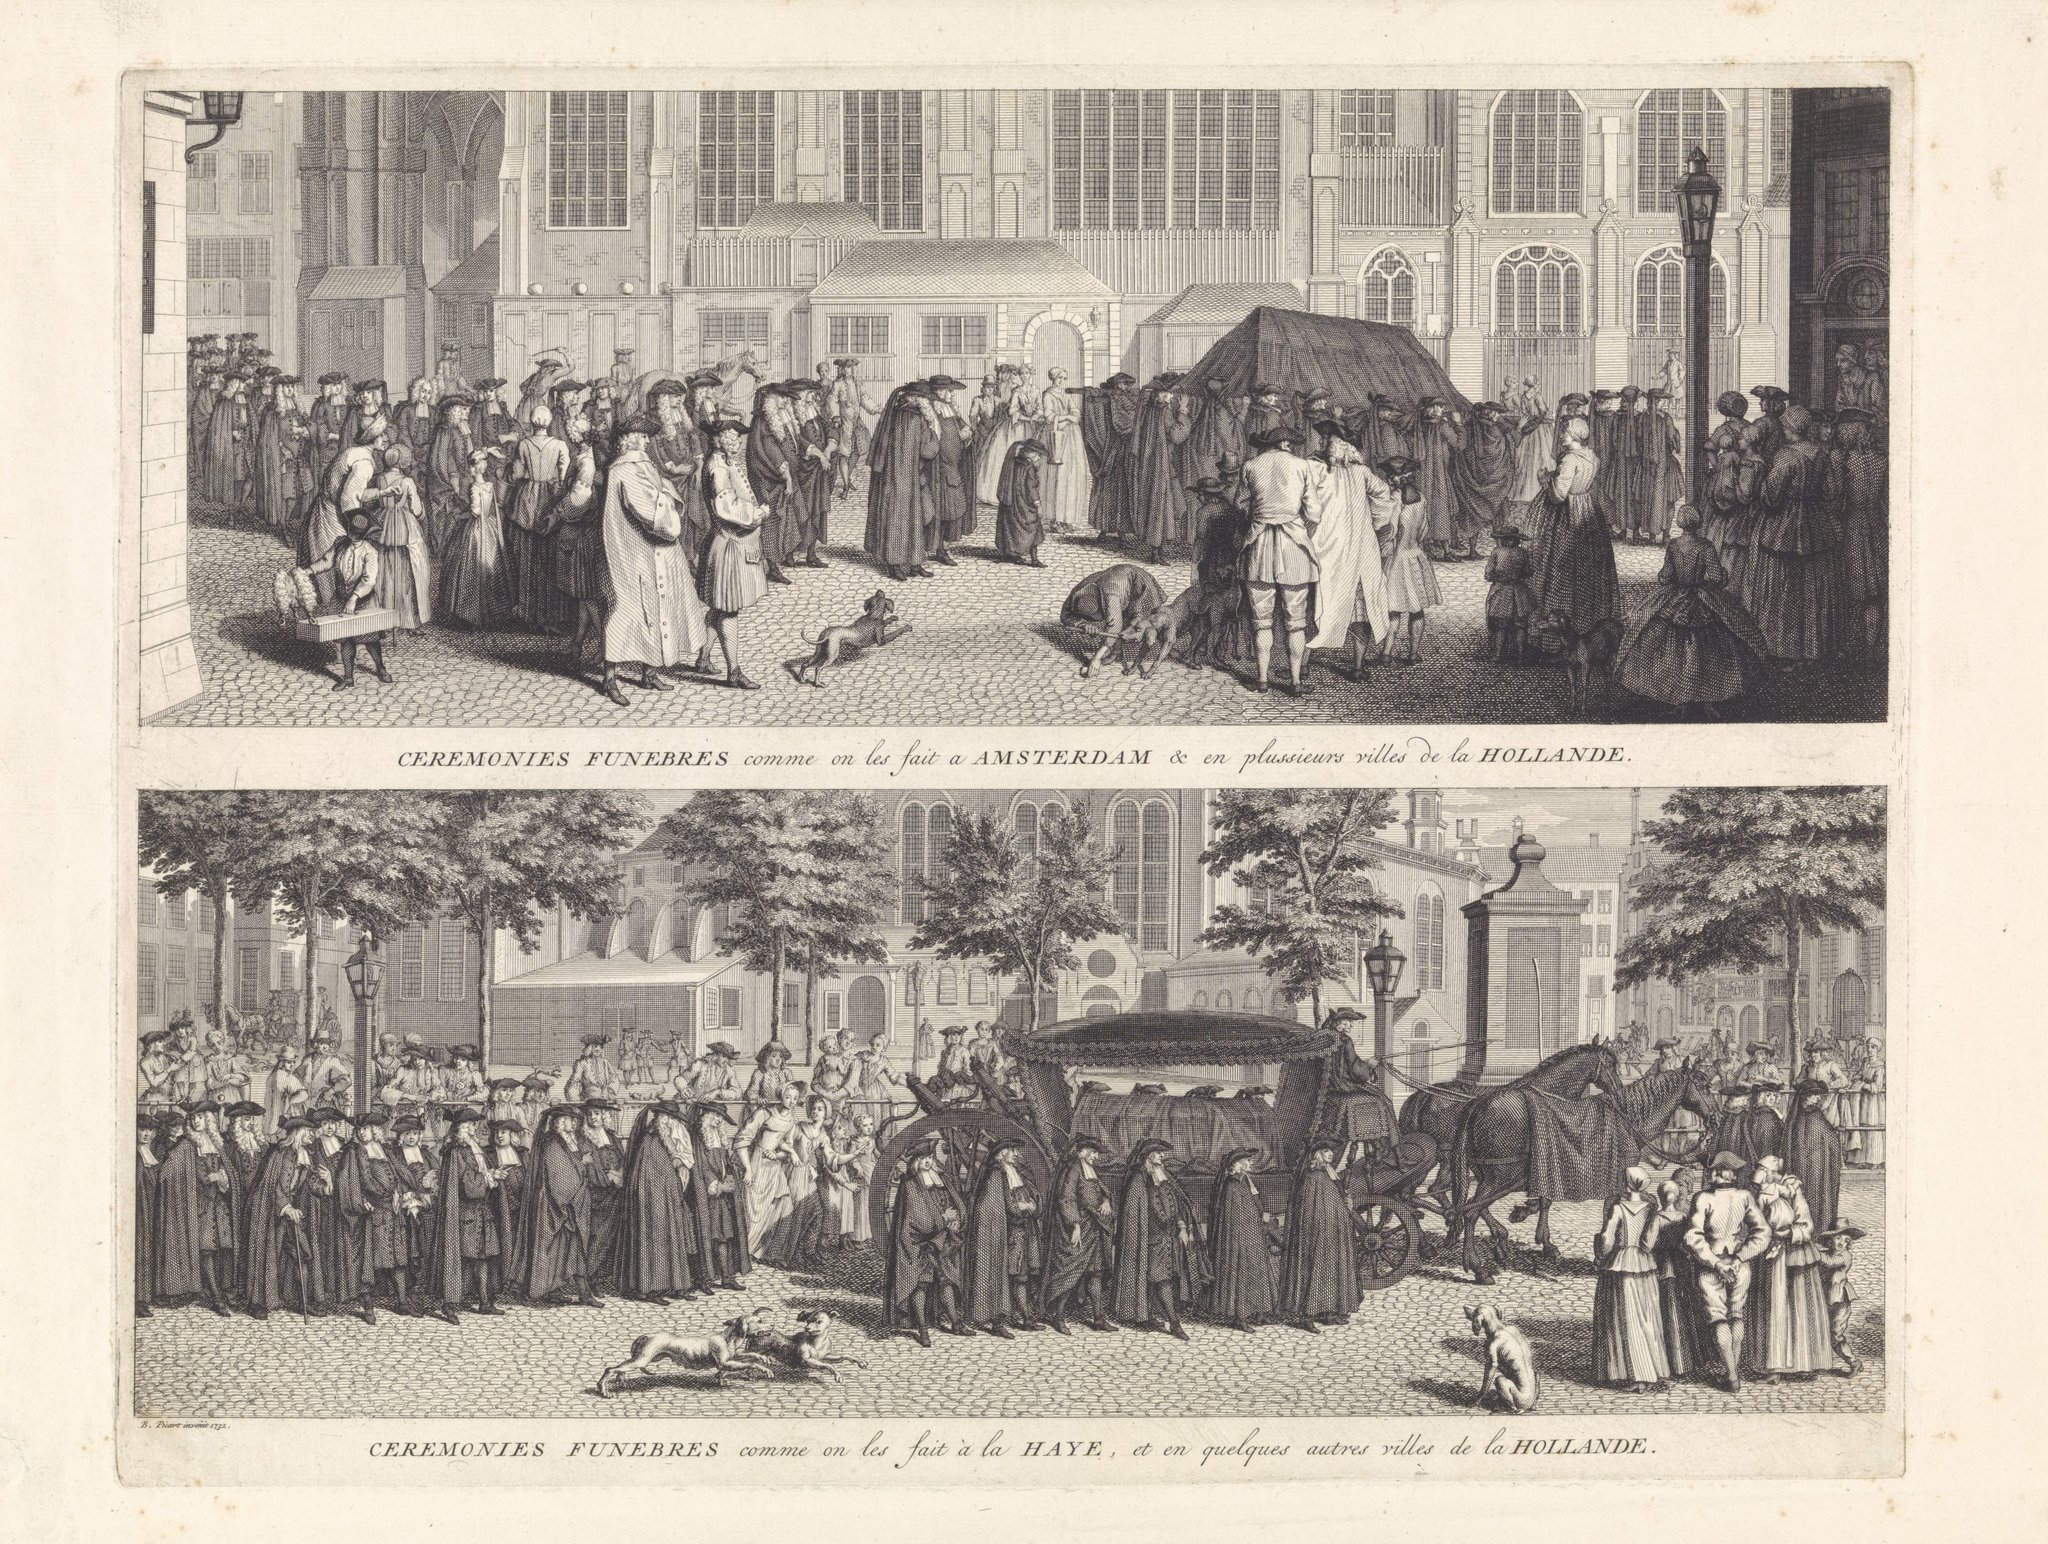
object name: print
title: Begrafenissen bij de gereformeerden te Amsterdam en Den Haag, ca. 1730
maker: bernard picart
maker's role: draughtsman, print maker, publisher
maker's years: 1673-1733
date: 1732-1736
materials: paper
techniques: engraving, etching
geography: amsterdam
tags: cortege, funeral procession, funerary ceremonial, the hague, amsterdam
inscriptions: collector's mark: Lugt 240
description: Prent ook gebruikt in: Picart, Bernard. Ceremonies et coutumes religieuses de tous les peuples du monde (...). 10 delen. Amsterdam: Jean Frederic Bernard, 1723-1743, deel 3 (1733), na p. 378. En in de Nederlandse vertaling: Picart, Bernard en Abraham Moubach. Naaukeurige beschryving der uitwendige godtsdienst-plichten, kerk-zeden en gewoontens van alle volkeren der waereldt : in een historisch verhaal (...). 6 delen. 's-Gravenhage: Rutgert Christoffel Alberts, 1727-1738, deel 5 (1736), na p. 350. En waarschijnlijk ook in de Engelse vertaling.